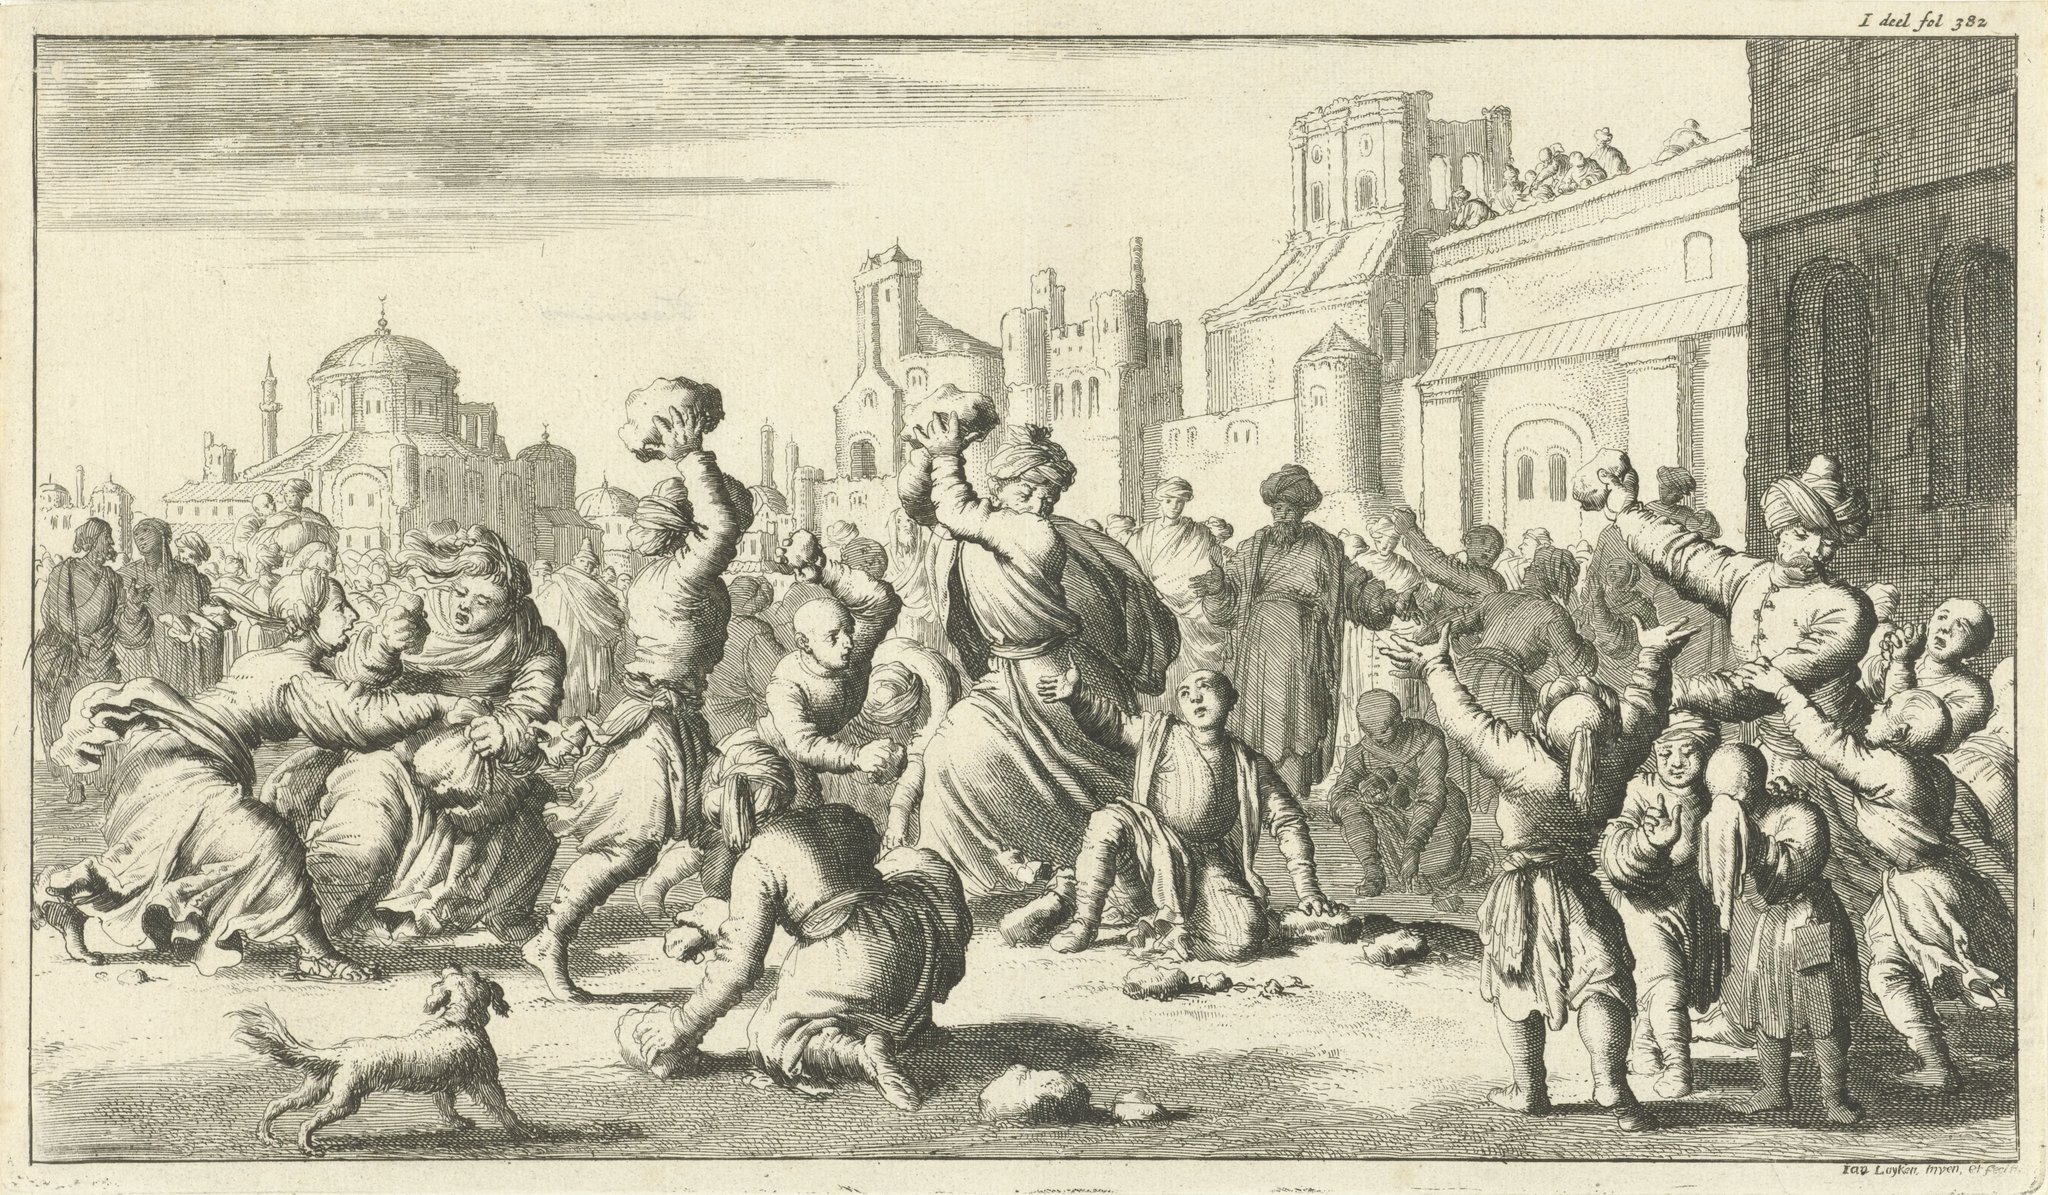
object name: book illustration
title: Stantvastigheden van een Armenische jongen, die gestenigt werd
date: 1682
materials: paper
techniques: etching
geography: amsterdam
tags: violent death, being killed; being mishandled and maltreated; seeking death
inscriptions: collector's mark: Lugt 2228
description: Illustratie opgenomen in: Tavernier, Jean Baptiste. De Zes Reizen, 3 delen. Amsterdam: weduwe Joannes van Someren, 1682, dl. 1.